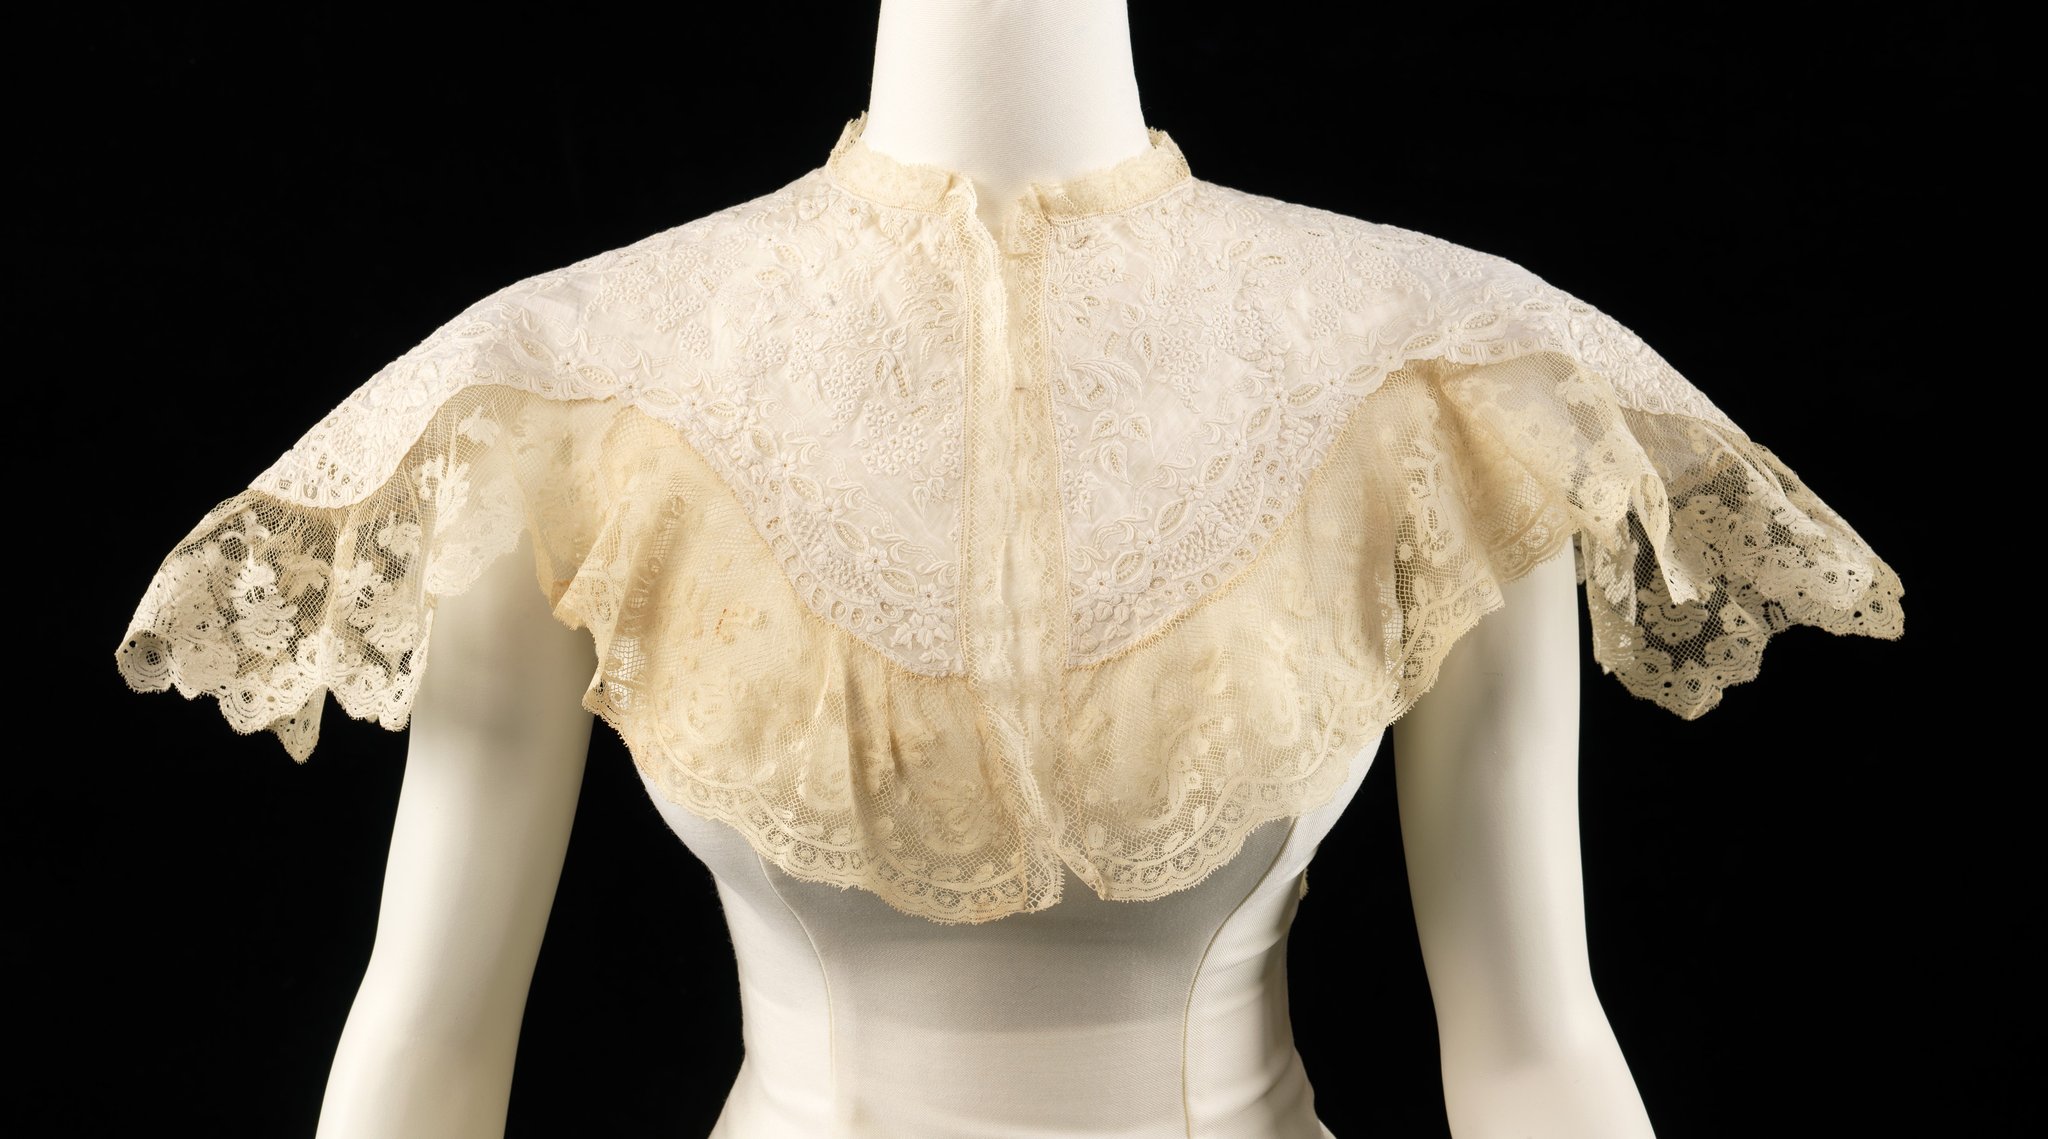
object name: collar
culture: french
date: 1835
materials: linen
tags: flowers